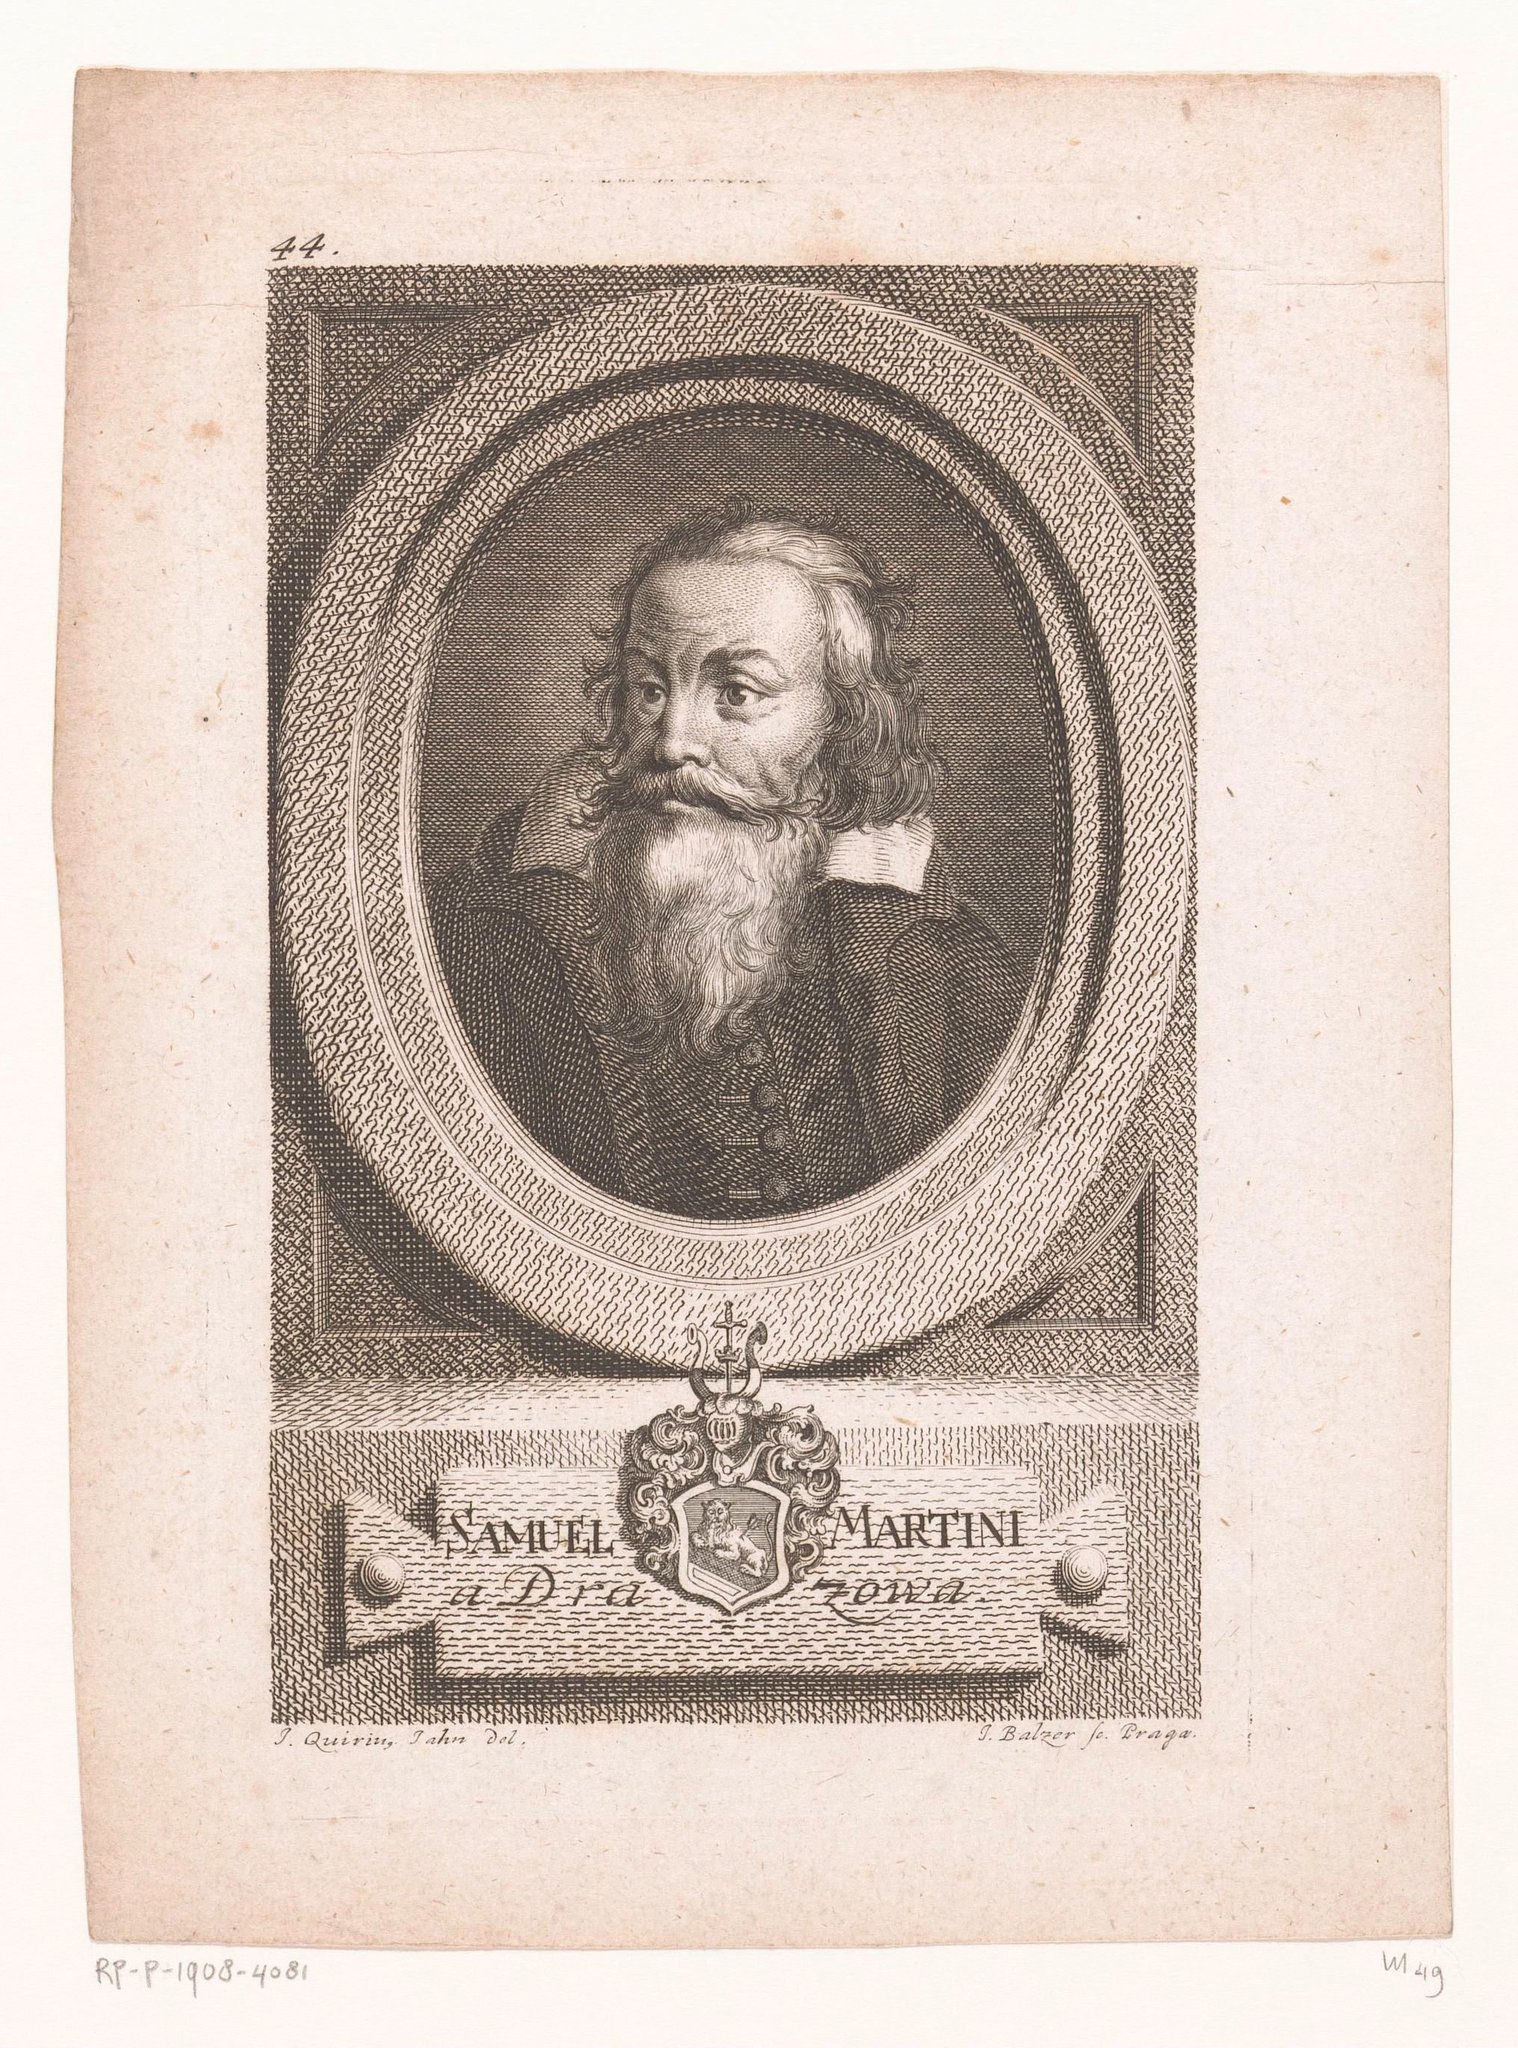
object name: print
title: Portret van Samuel Martini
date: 1749-1799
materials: paper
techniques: engraving, etching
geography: prague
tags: historical persons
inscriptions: collector's mark: Lugt 2228